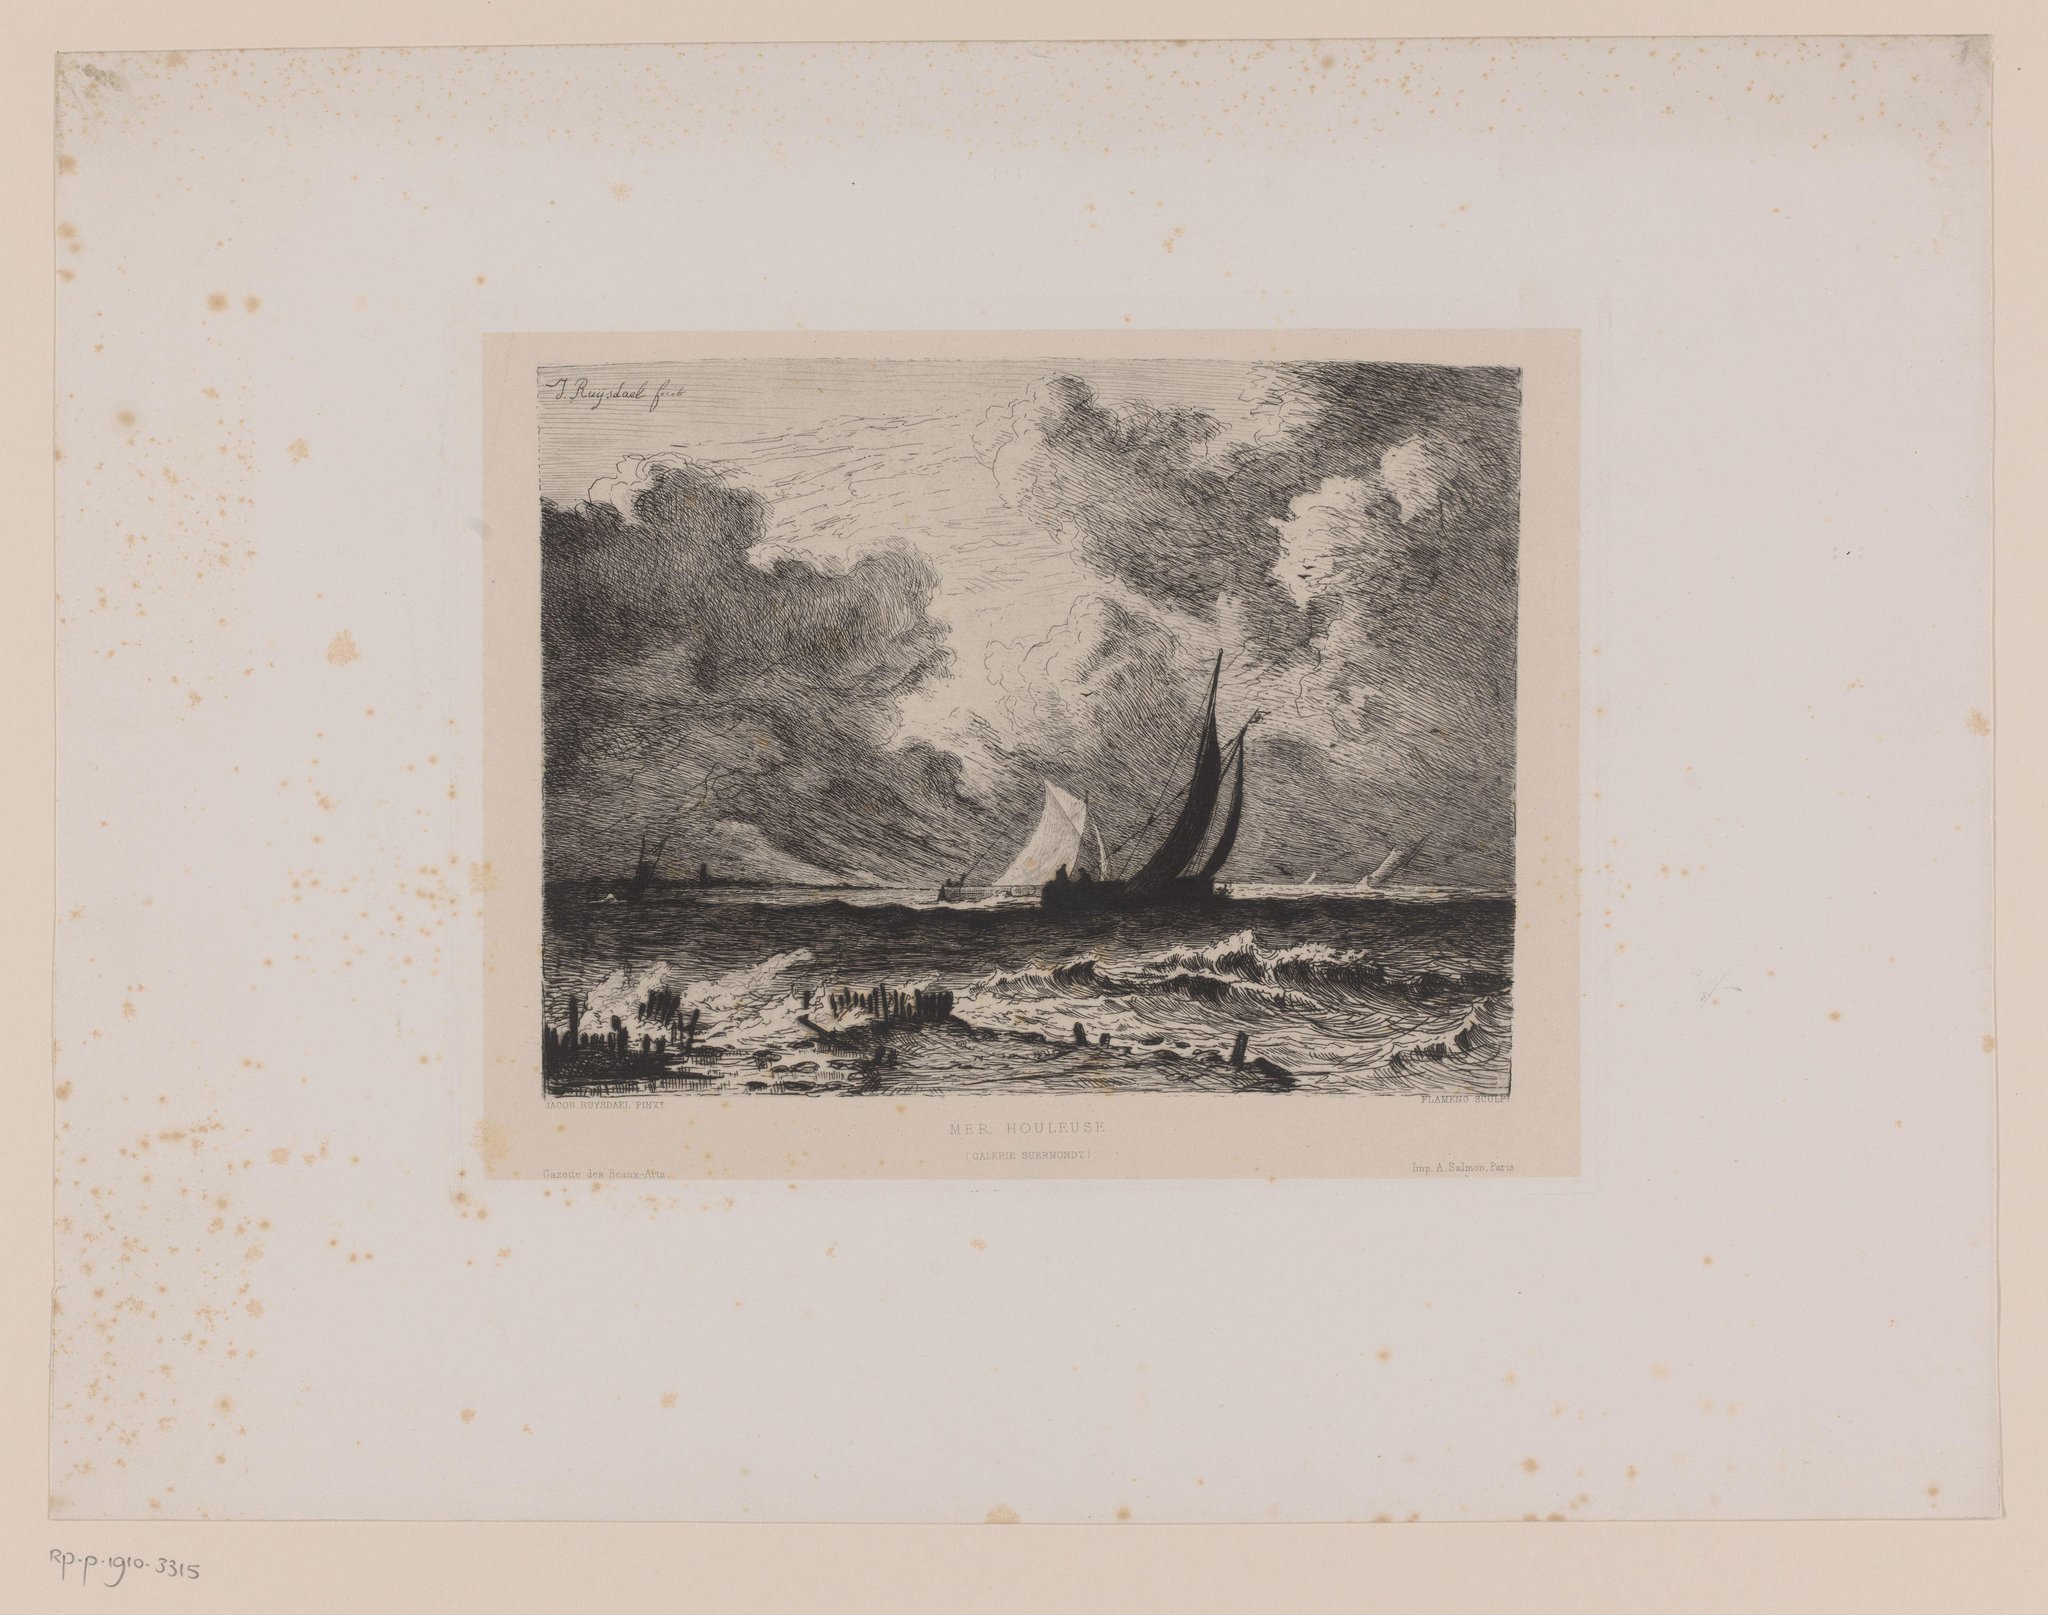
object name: print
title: Stormachtige zee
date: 1869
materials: paper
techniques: drypoint, etching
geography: paris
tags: sailing-ship, sailing-boat, storm at sea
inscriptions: collector's mark: Lugt 2228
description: Prent uit: Gazette des beaux-arts (1869), dl. 1, p. 182.